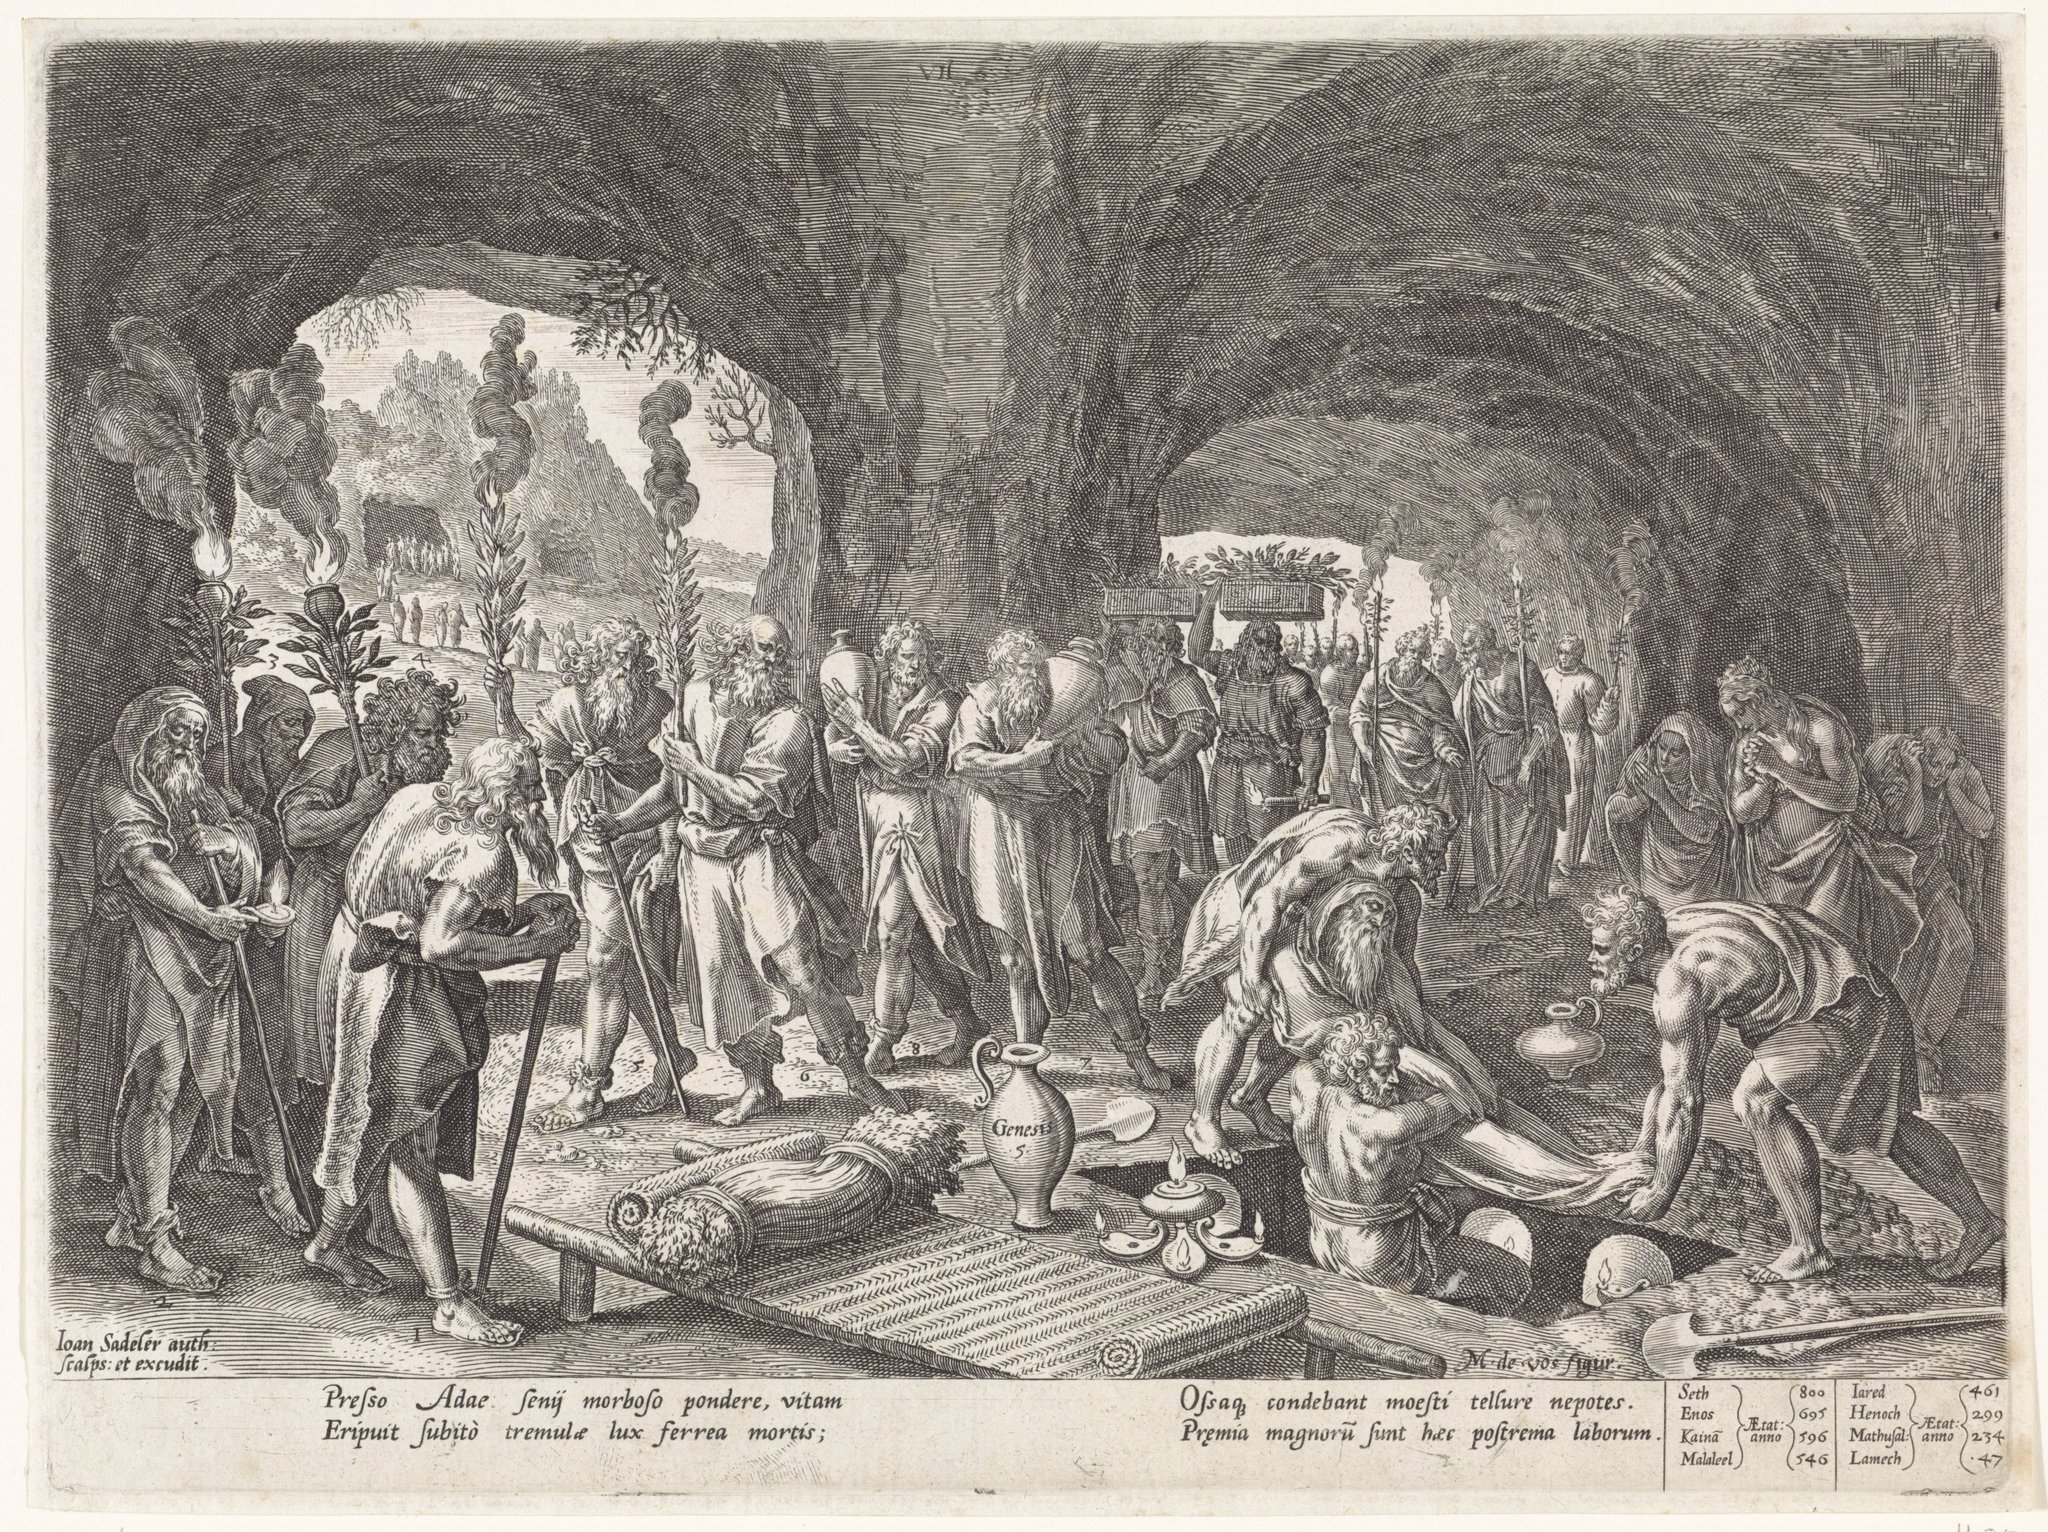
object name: print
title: Bonorum et Malorum consensio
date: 1586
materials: paper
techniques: engraving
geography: antwerp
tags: adam's burial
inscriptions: collector's mark: Lugt 10, collector's mark: Lugt 11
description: Adam wordt door al zijn nazaten begraven in een grot. De prent heeft een Latijns onderschrift.